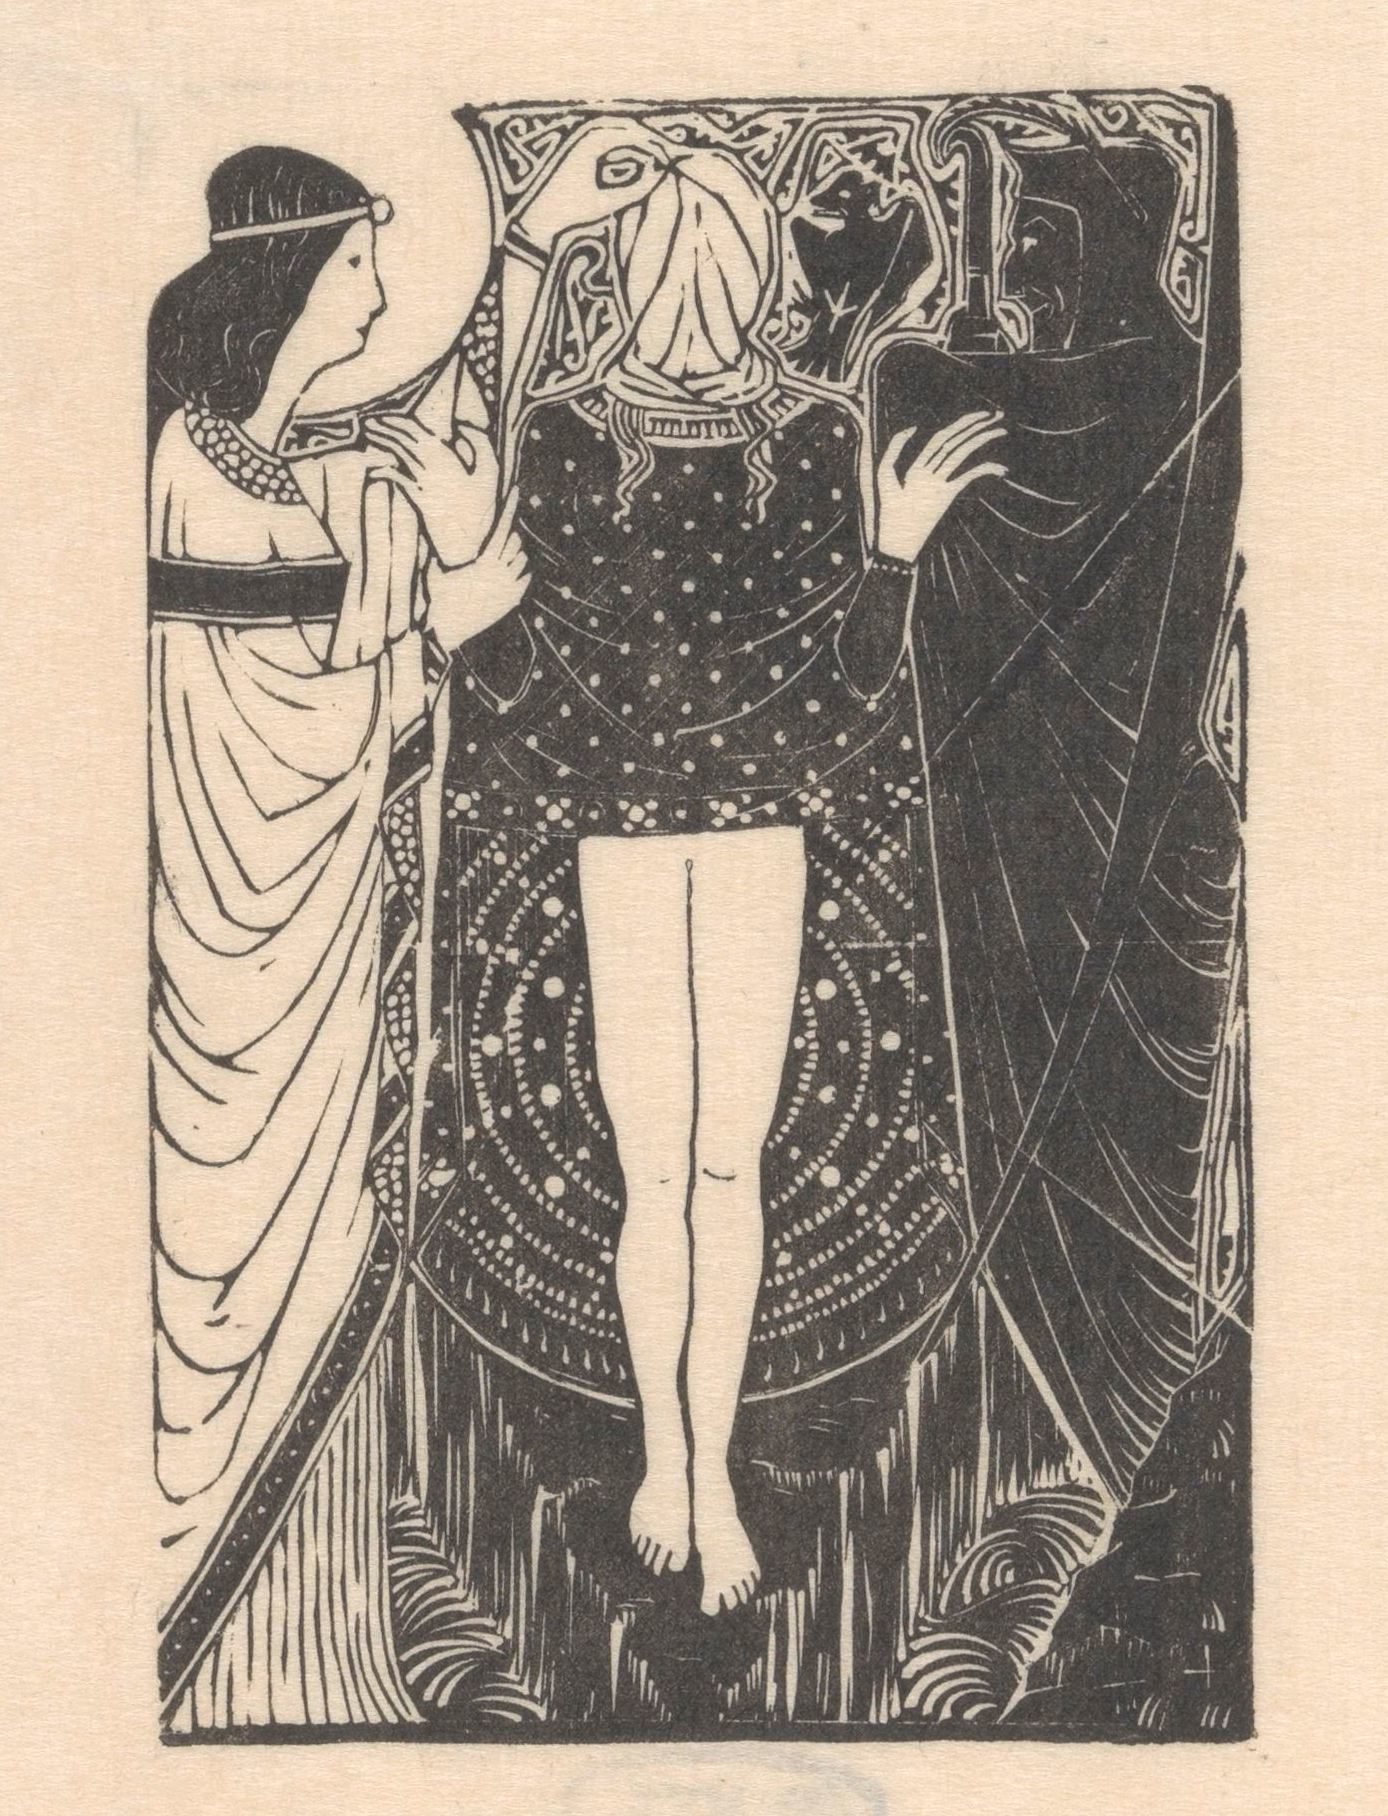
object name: print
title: Geblinddoekte vrouw tussen twee figuren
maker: mathieu lauweriks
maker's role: designer, draughtsman, print maker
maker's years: 1864-1932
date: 1895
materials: paper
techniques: woodcut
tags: man between good and evil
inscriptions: collector's mark: Lugt 2228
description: Prent mogelijk gebruikt voor: Multatuli, 'Geschiedenissen van gezag VIII', Licht en waarheid. Orgaan van de vereeniging 'Wie Denkt Overwint'. Amsterdam: Wie Denkt Overwint, 27 juli 1895. Het betreft een postume afdruk.